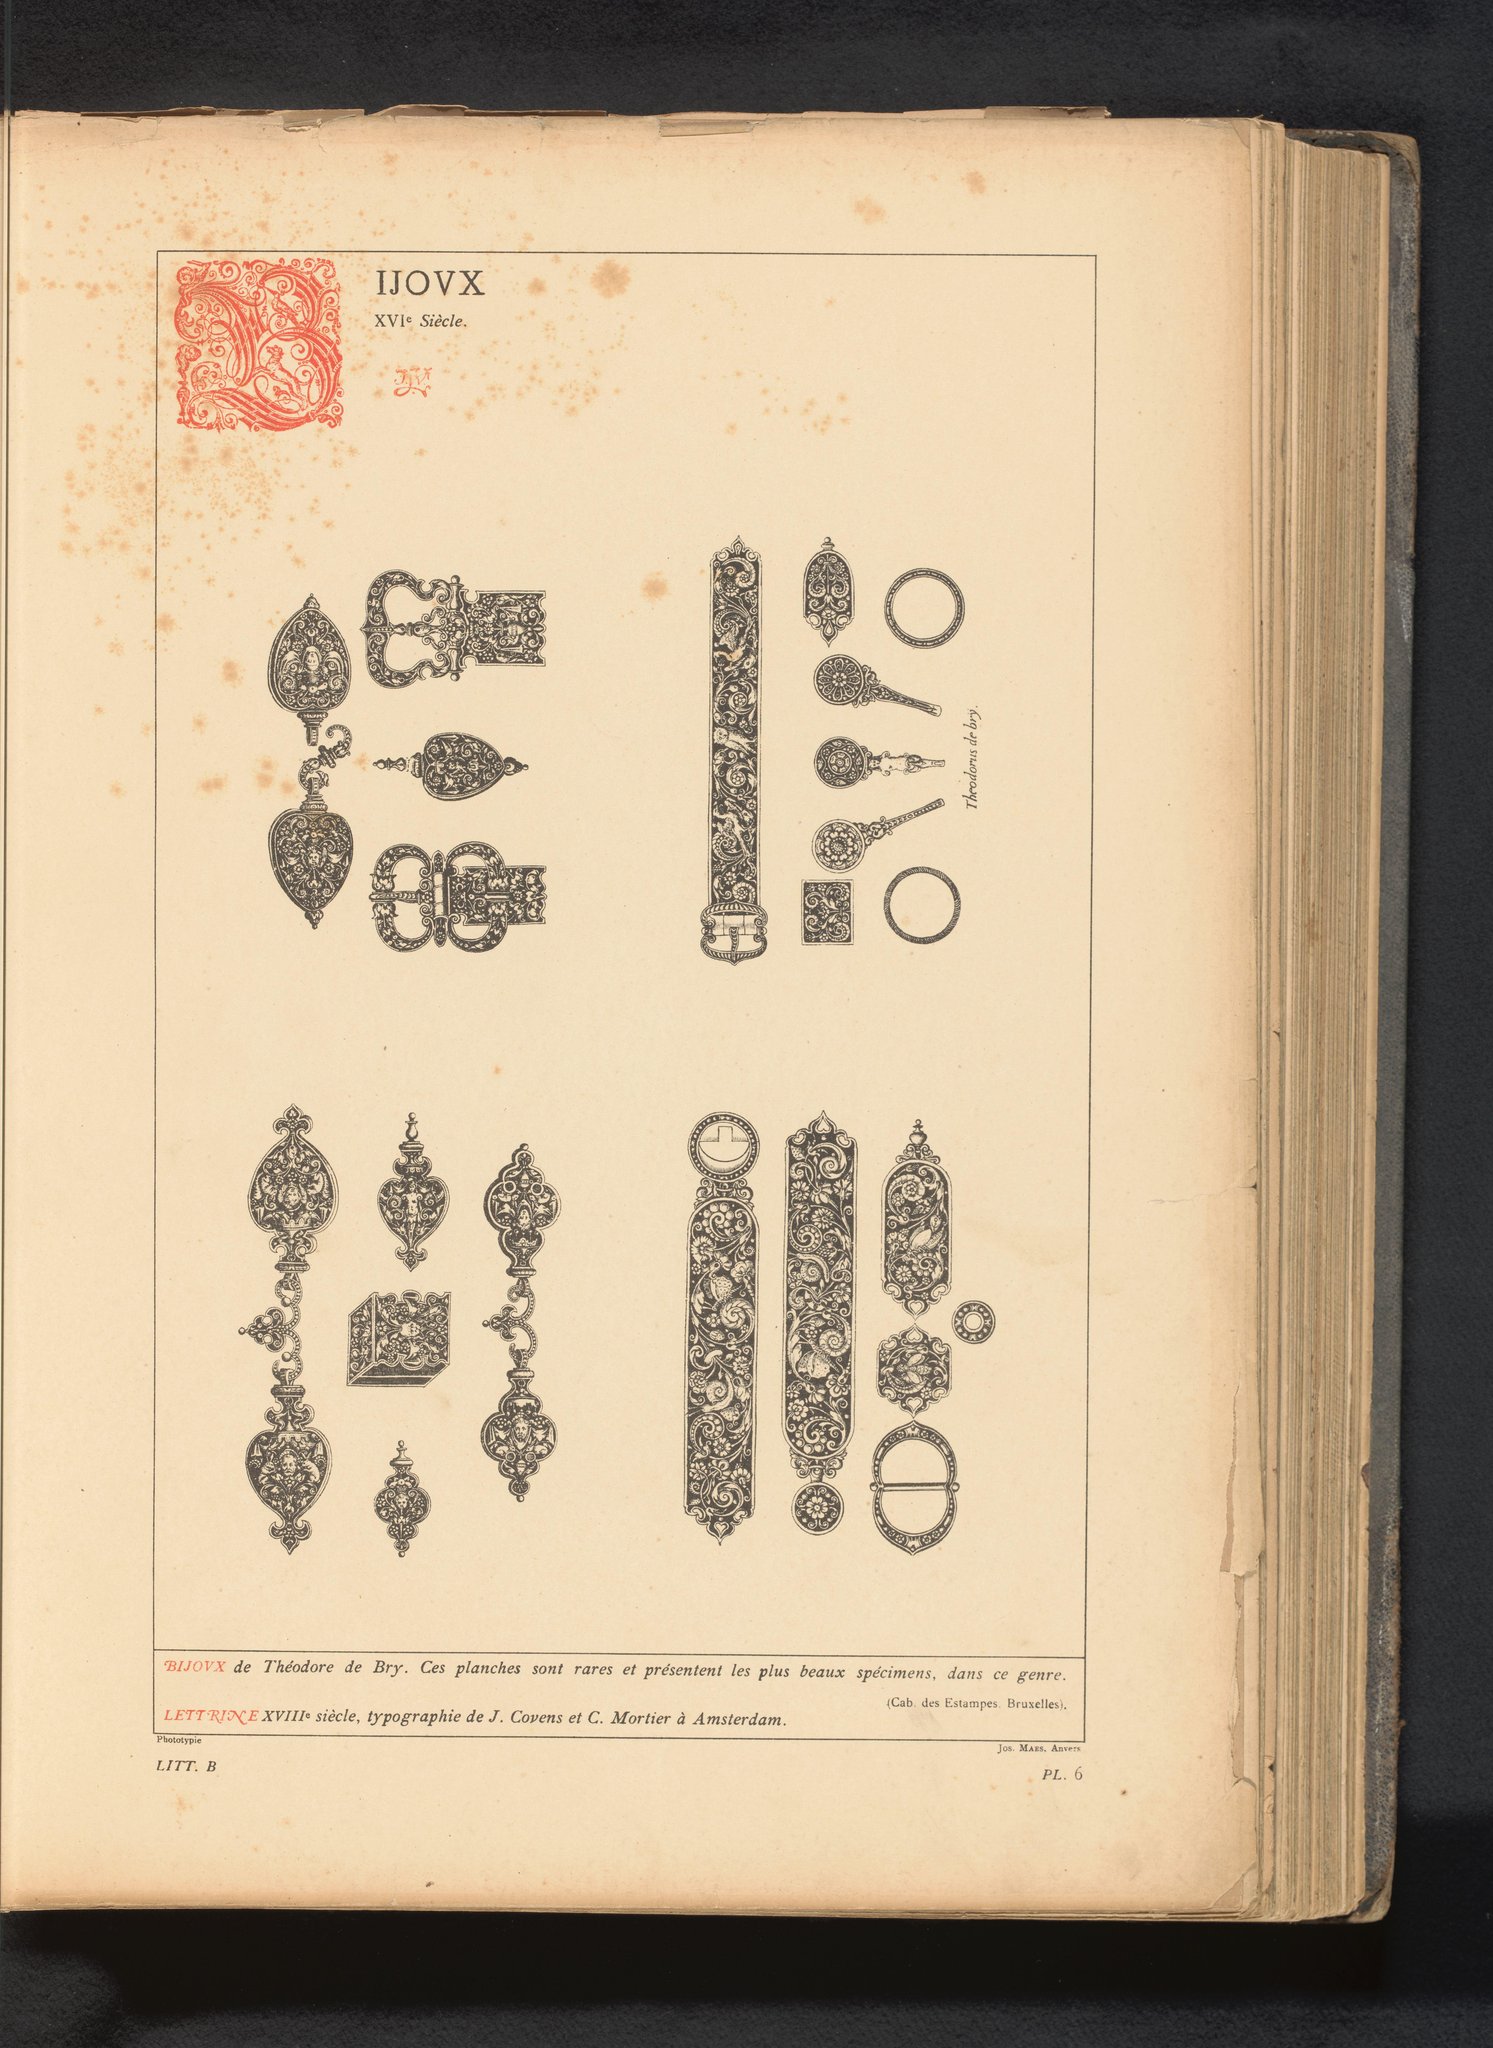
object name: page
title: Reproductie van vier prenten met juwelen door Theodor de Bry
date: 1875-1880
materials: paper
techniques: photolithography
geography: amsterdam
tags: ornaments, jewels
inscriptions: inscription: ‘LITT: B. - PL. 6.’, inscription: ‘Bijoux de Théodore (...)’, monogram: ‘JJvY’